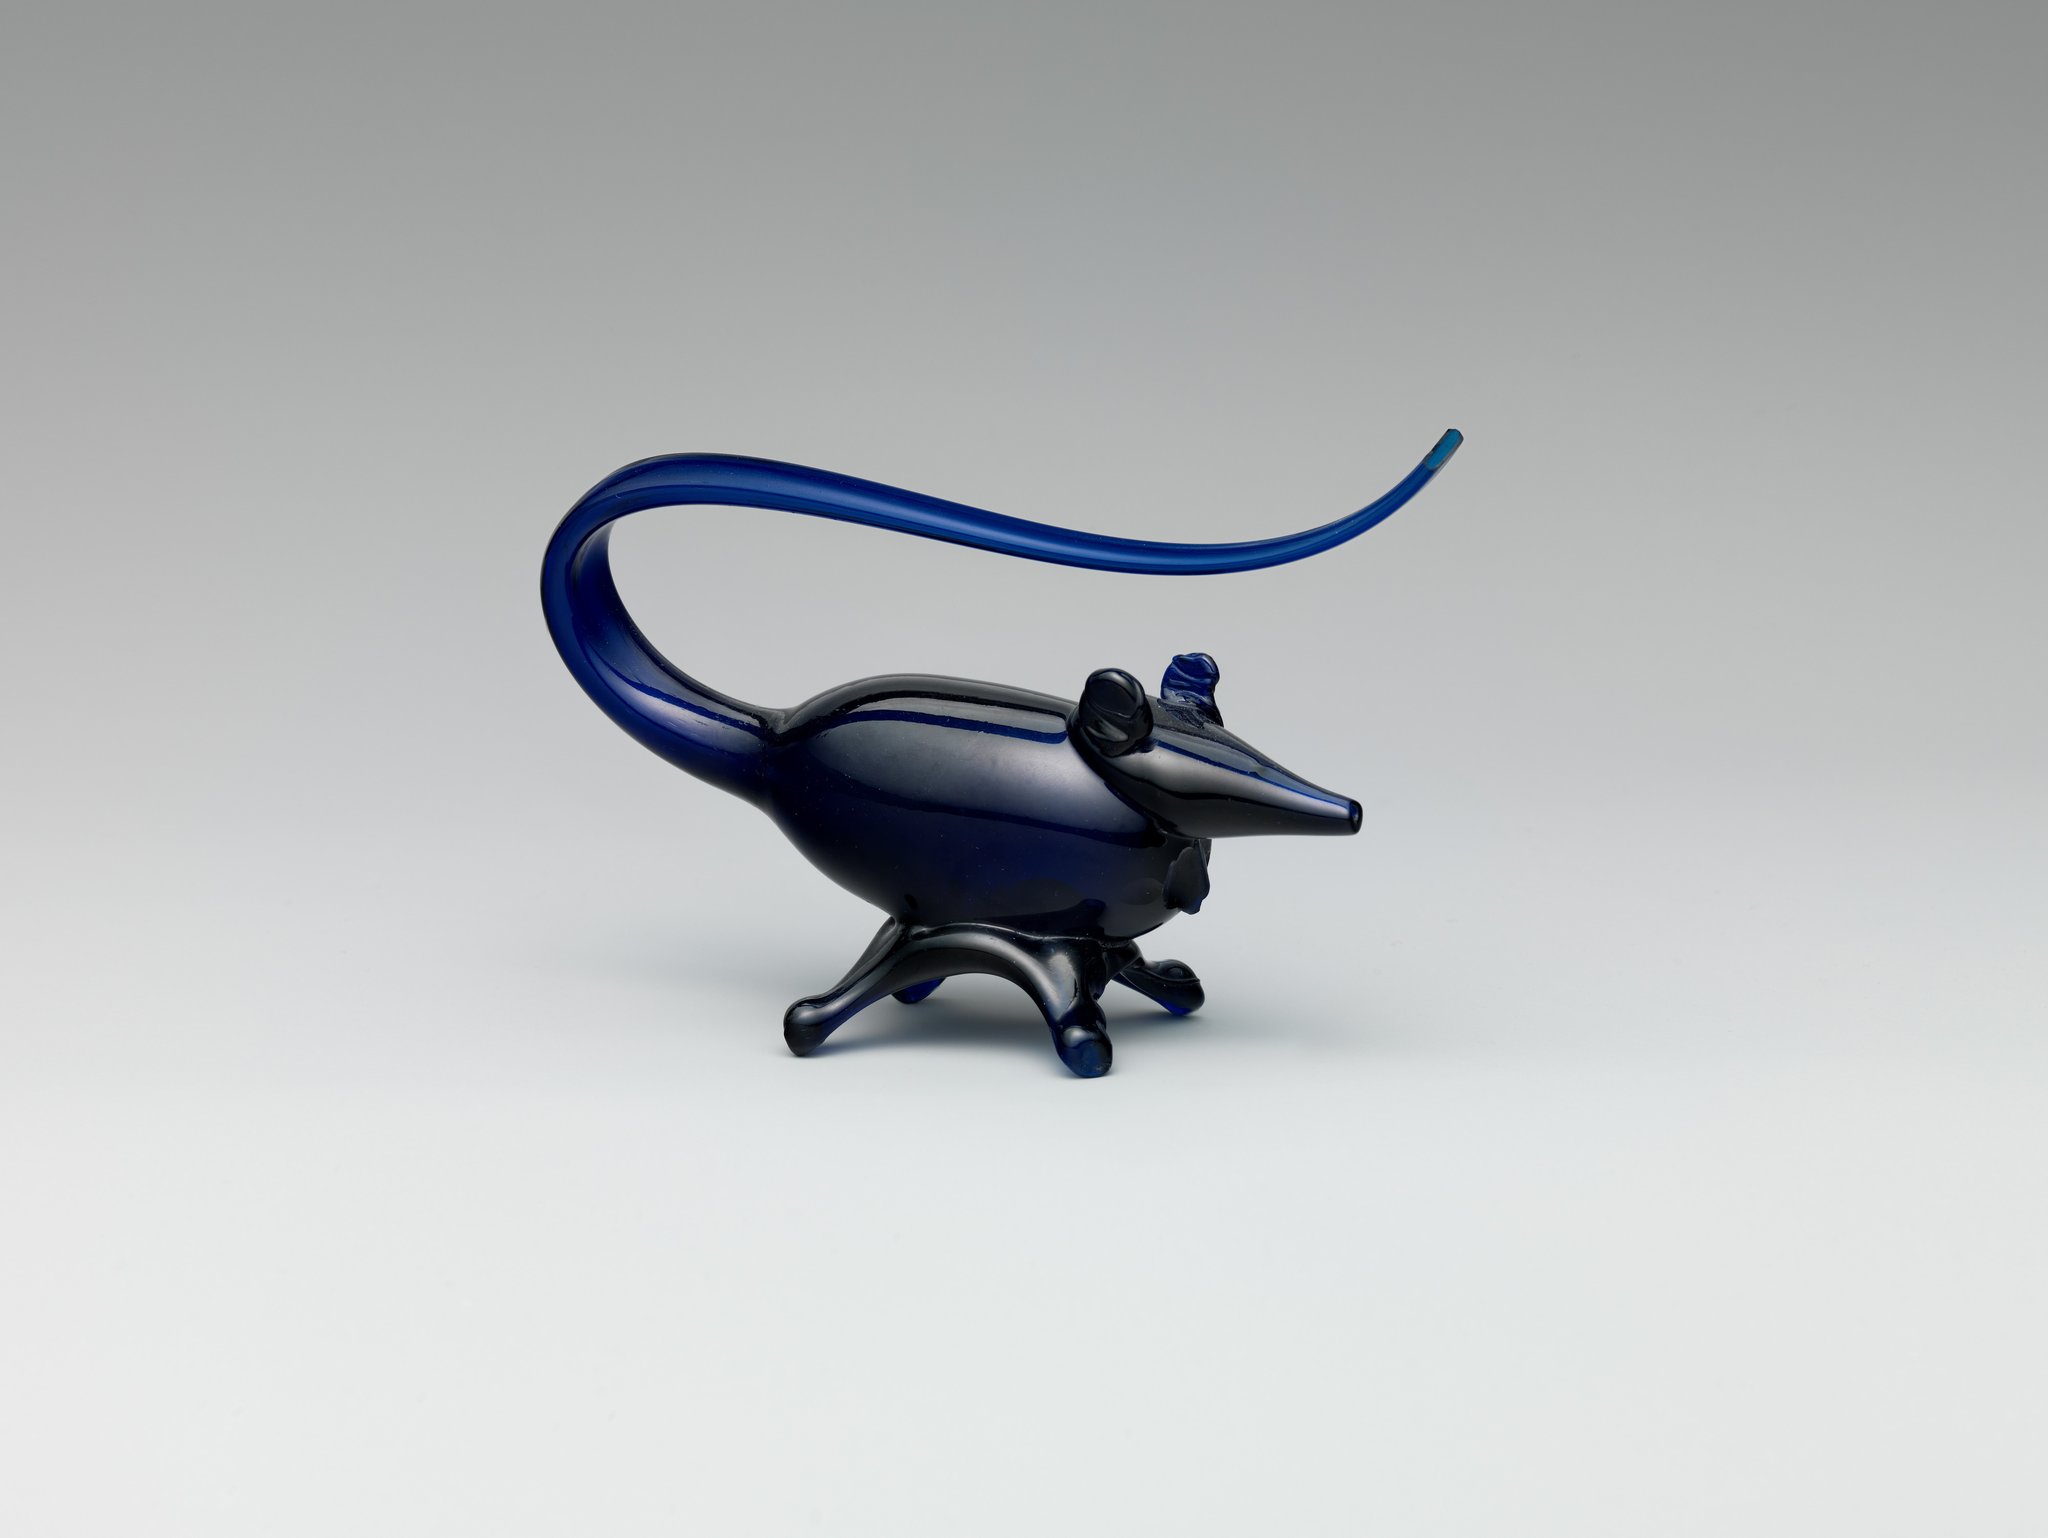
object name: figure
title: Figure of a Mouse in Deep Blue Glass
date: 1801-1900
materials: glass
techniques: glassblowing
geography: iran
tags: mice